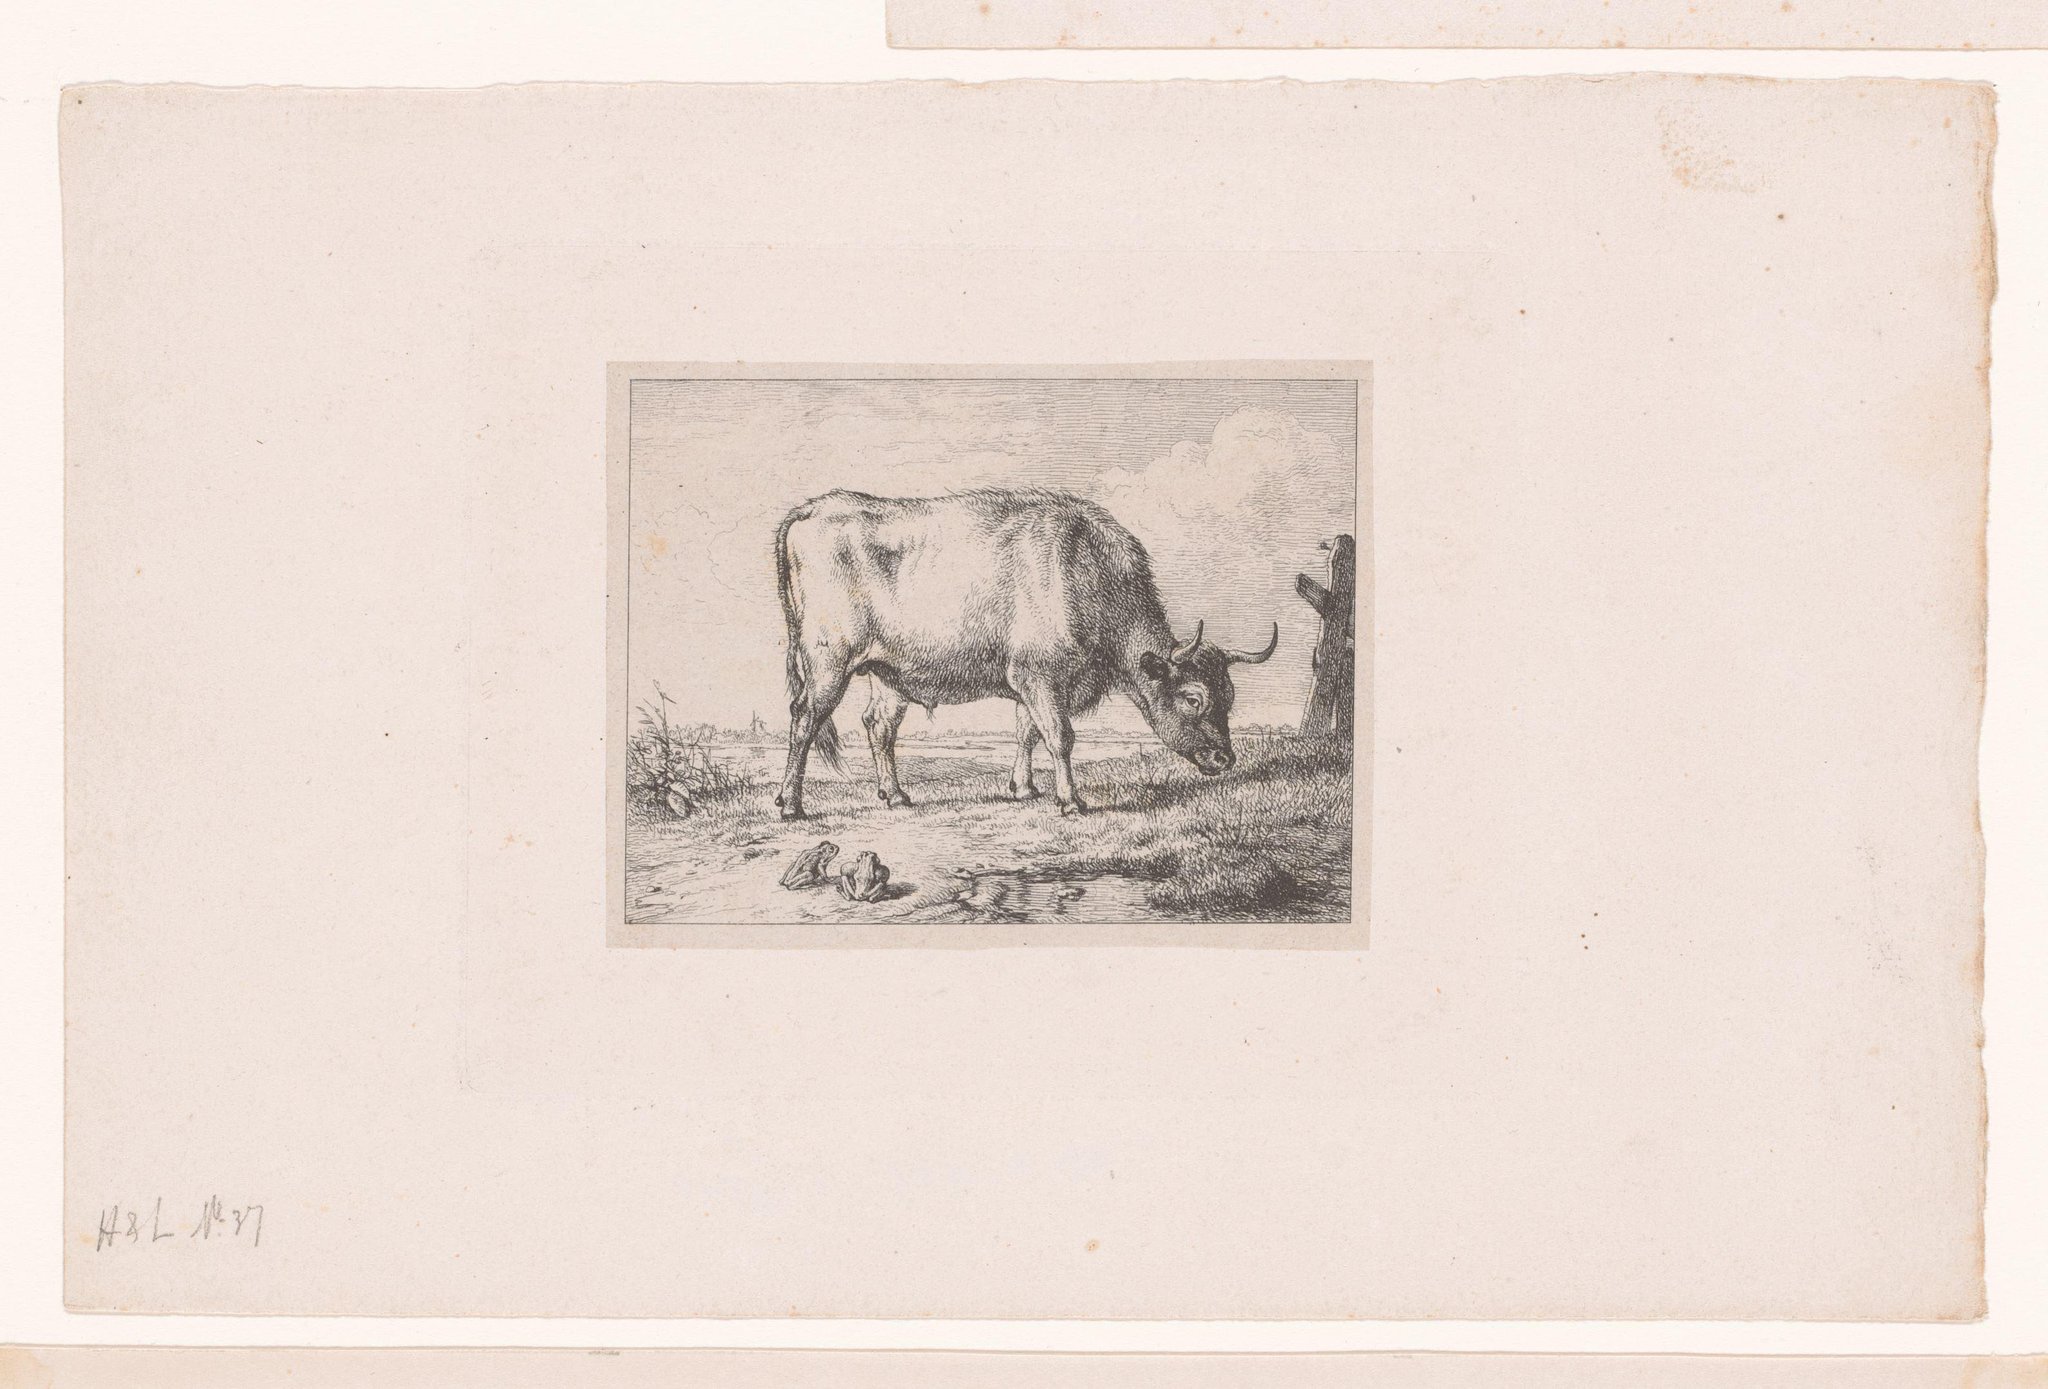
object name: print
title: Fabels van La Fontaine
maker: eugène verboeckhoven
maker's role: draughtsman, painter, print maker, printer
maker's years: 1798-1881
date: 1830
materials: paper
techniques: etching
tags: tailless amphibians: frog, fable of the frog and the cow, cow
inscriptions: collector's mark: Lugt 2228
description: Prent maakt deel uit van een serie van acht prenten met scènes uit de fabels van Jean de La Fontaine.